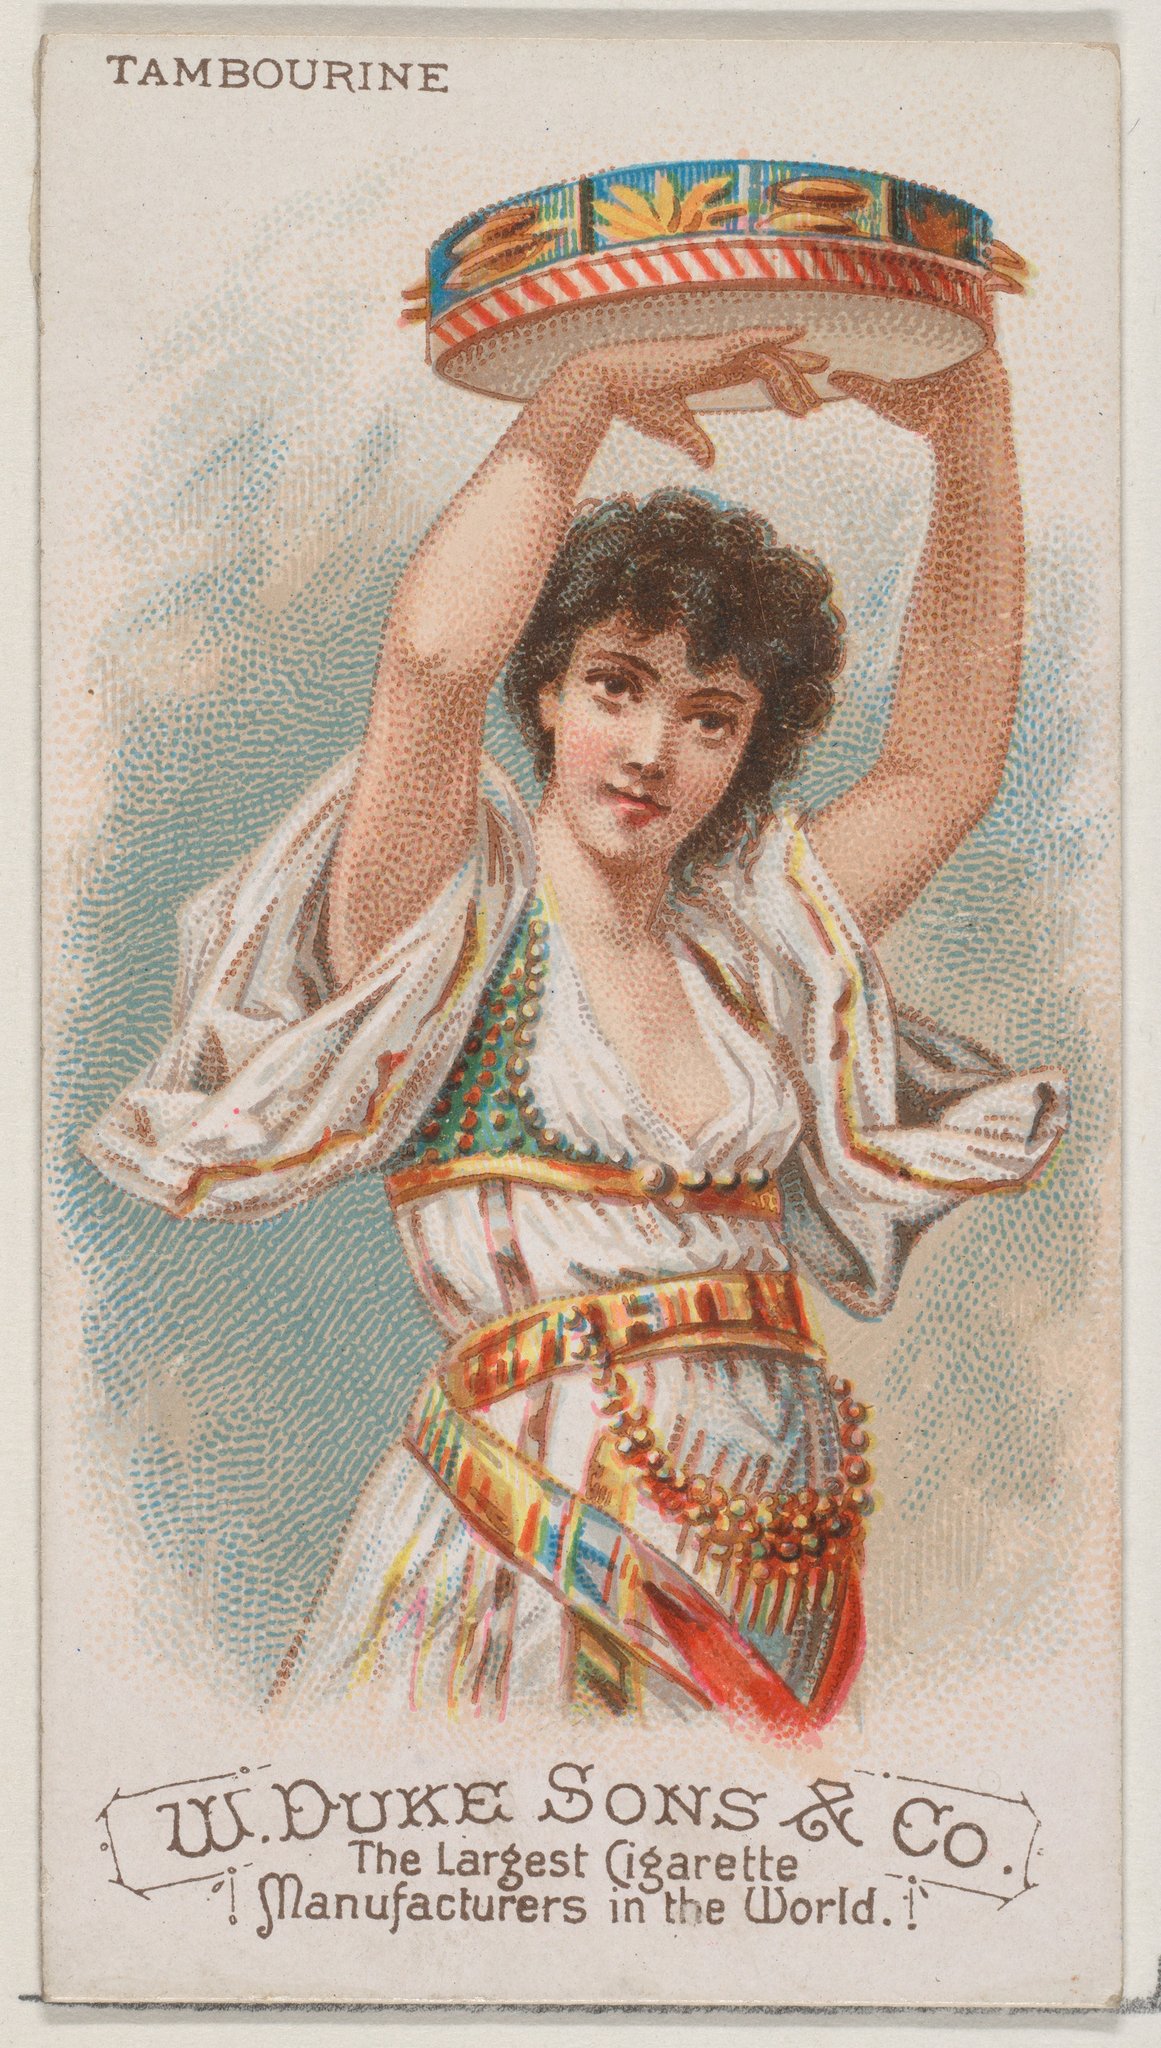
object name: print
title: Tamborine, from the Musical Instruments series (N82) for Duke brand cigarettes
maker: w. duke, sons & co.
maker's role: publisher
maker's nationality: american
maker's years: 1870-1920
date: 1888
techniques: color lithograph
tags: musical instruments,women,musicians